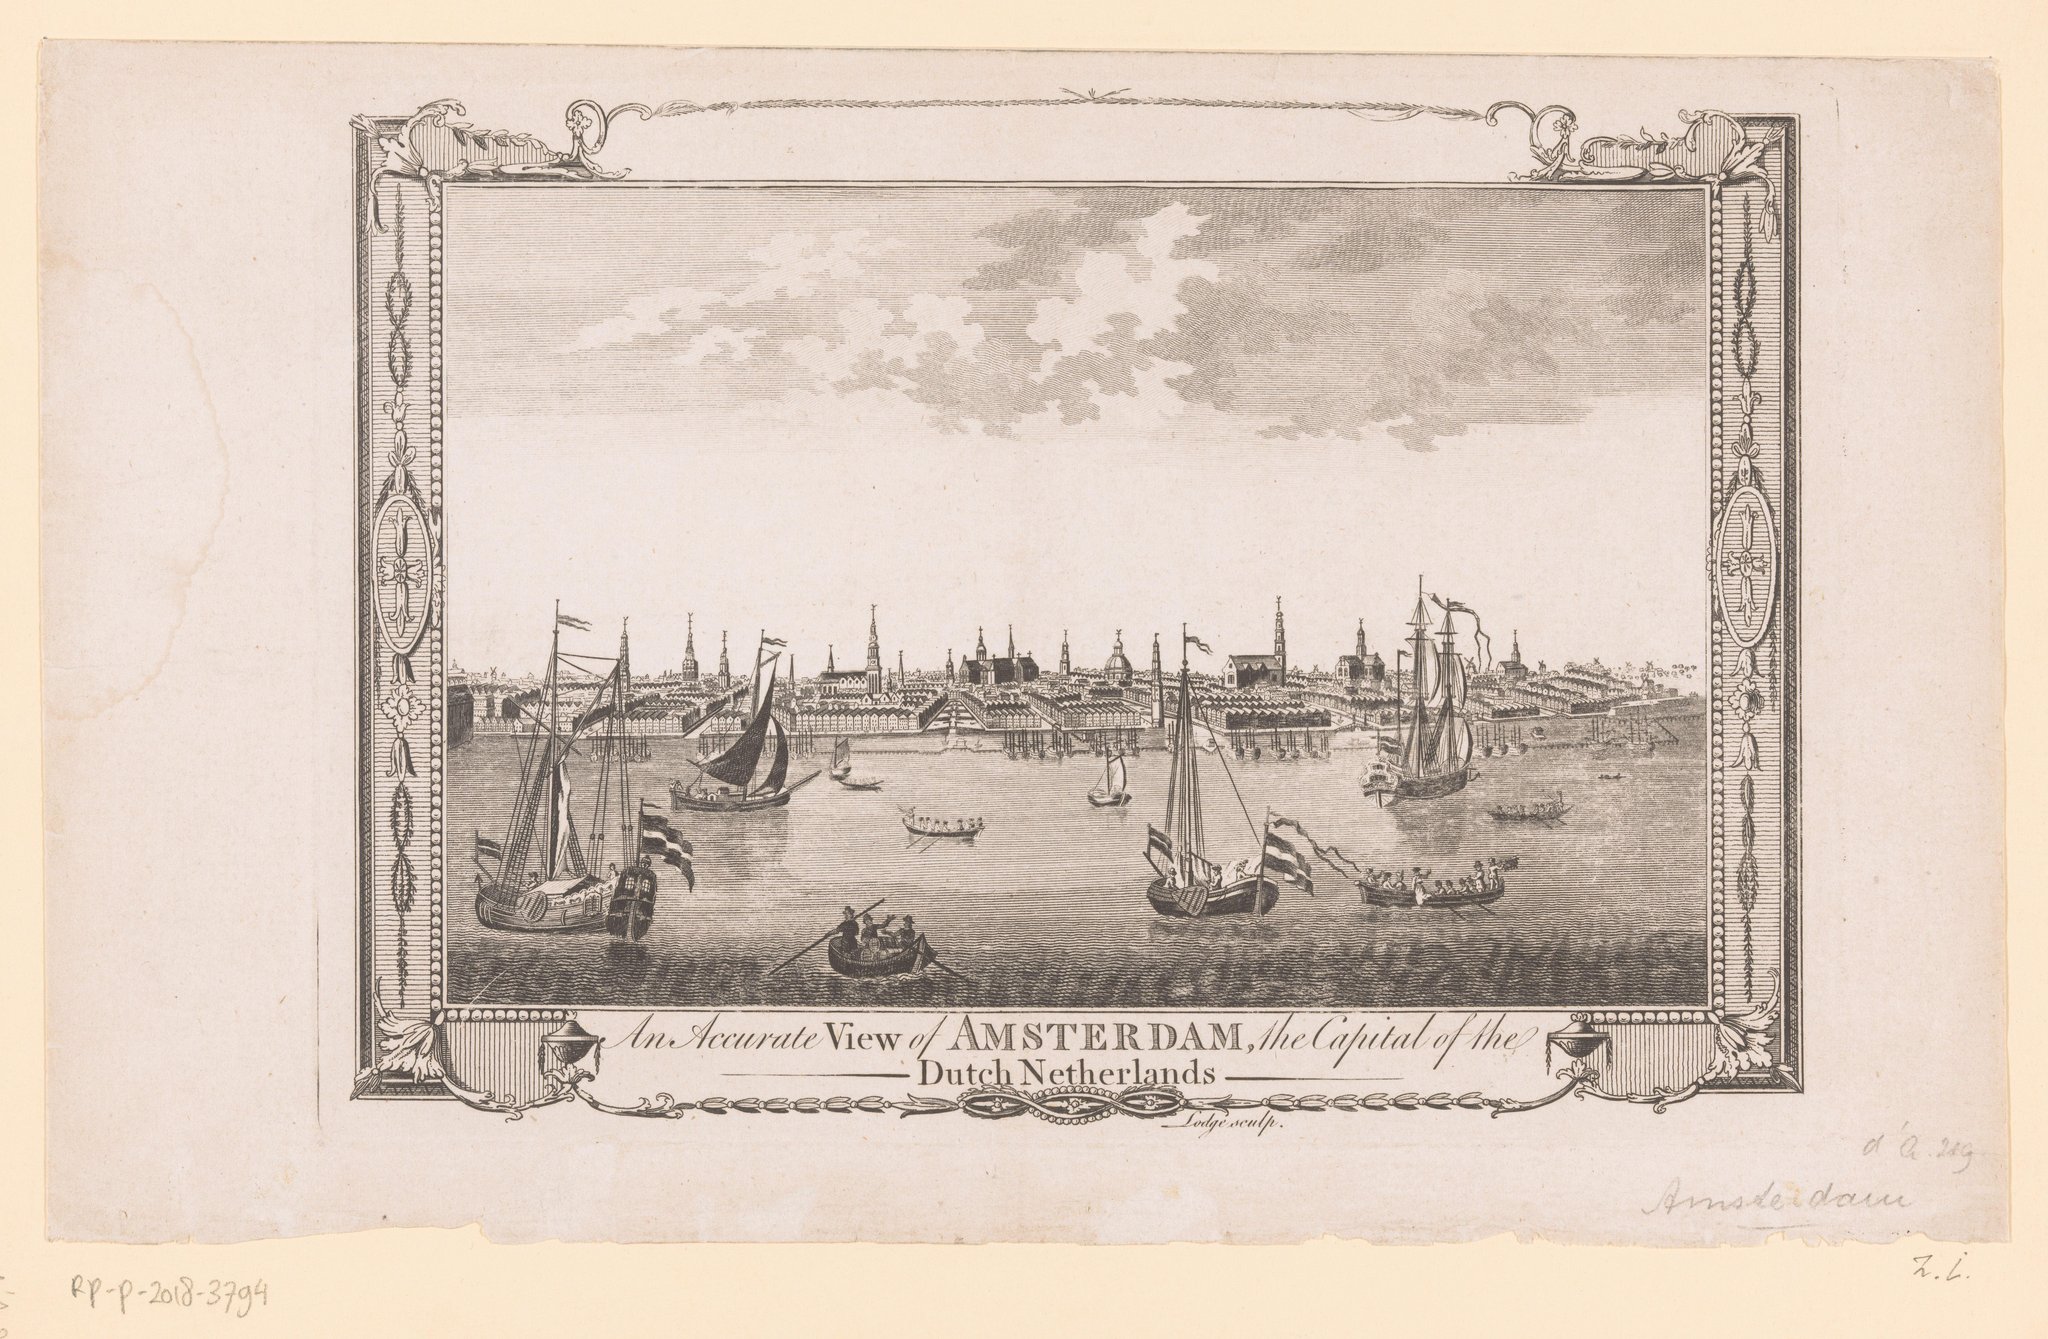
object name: print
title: Gezicht op Amsterdam vanaf het IJ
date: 1783-1789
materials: paper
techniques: engraving, etching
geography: london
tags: harbour, city-view, and landscape with man-made constructions, ships (in general) - cc - more than one ship, amsterdam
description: Prent uit: Millar, George Henry. The New, Complete, Authentic, and Universal System of Geography (...). Londen: Alexander Hogg, 1783, latere druk 1789.